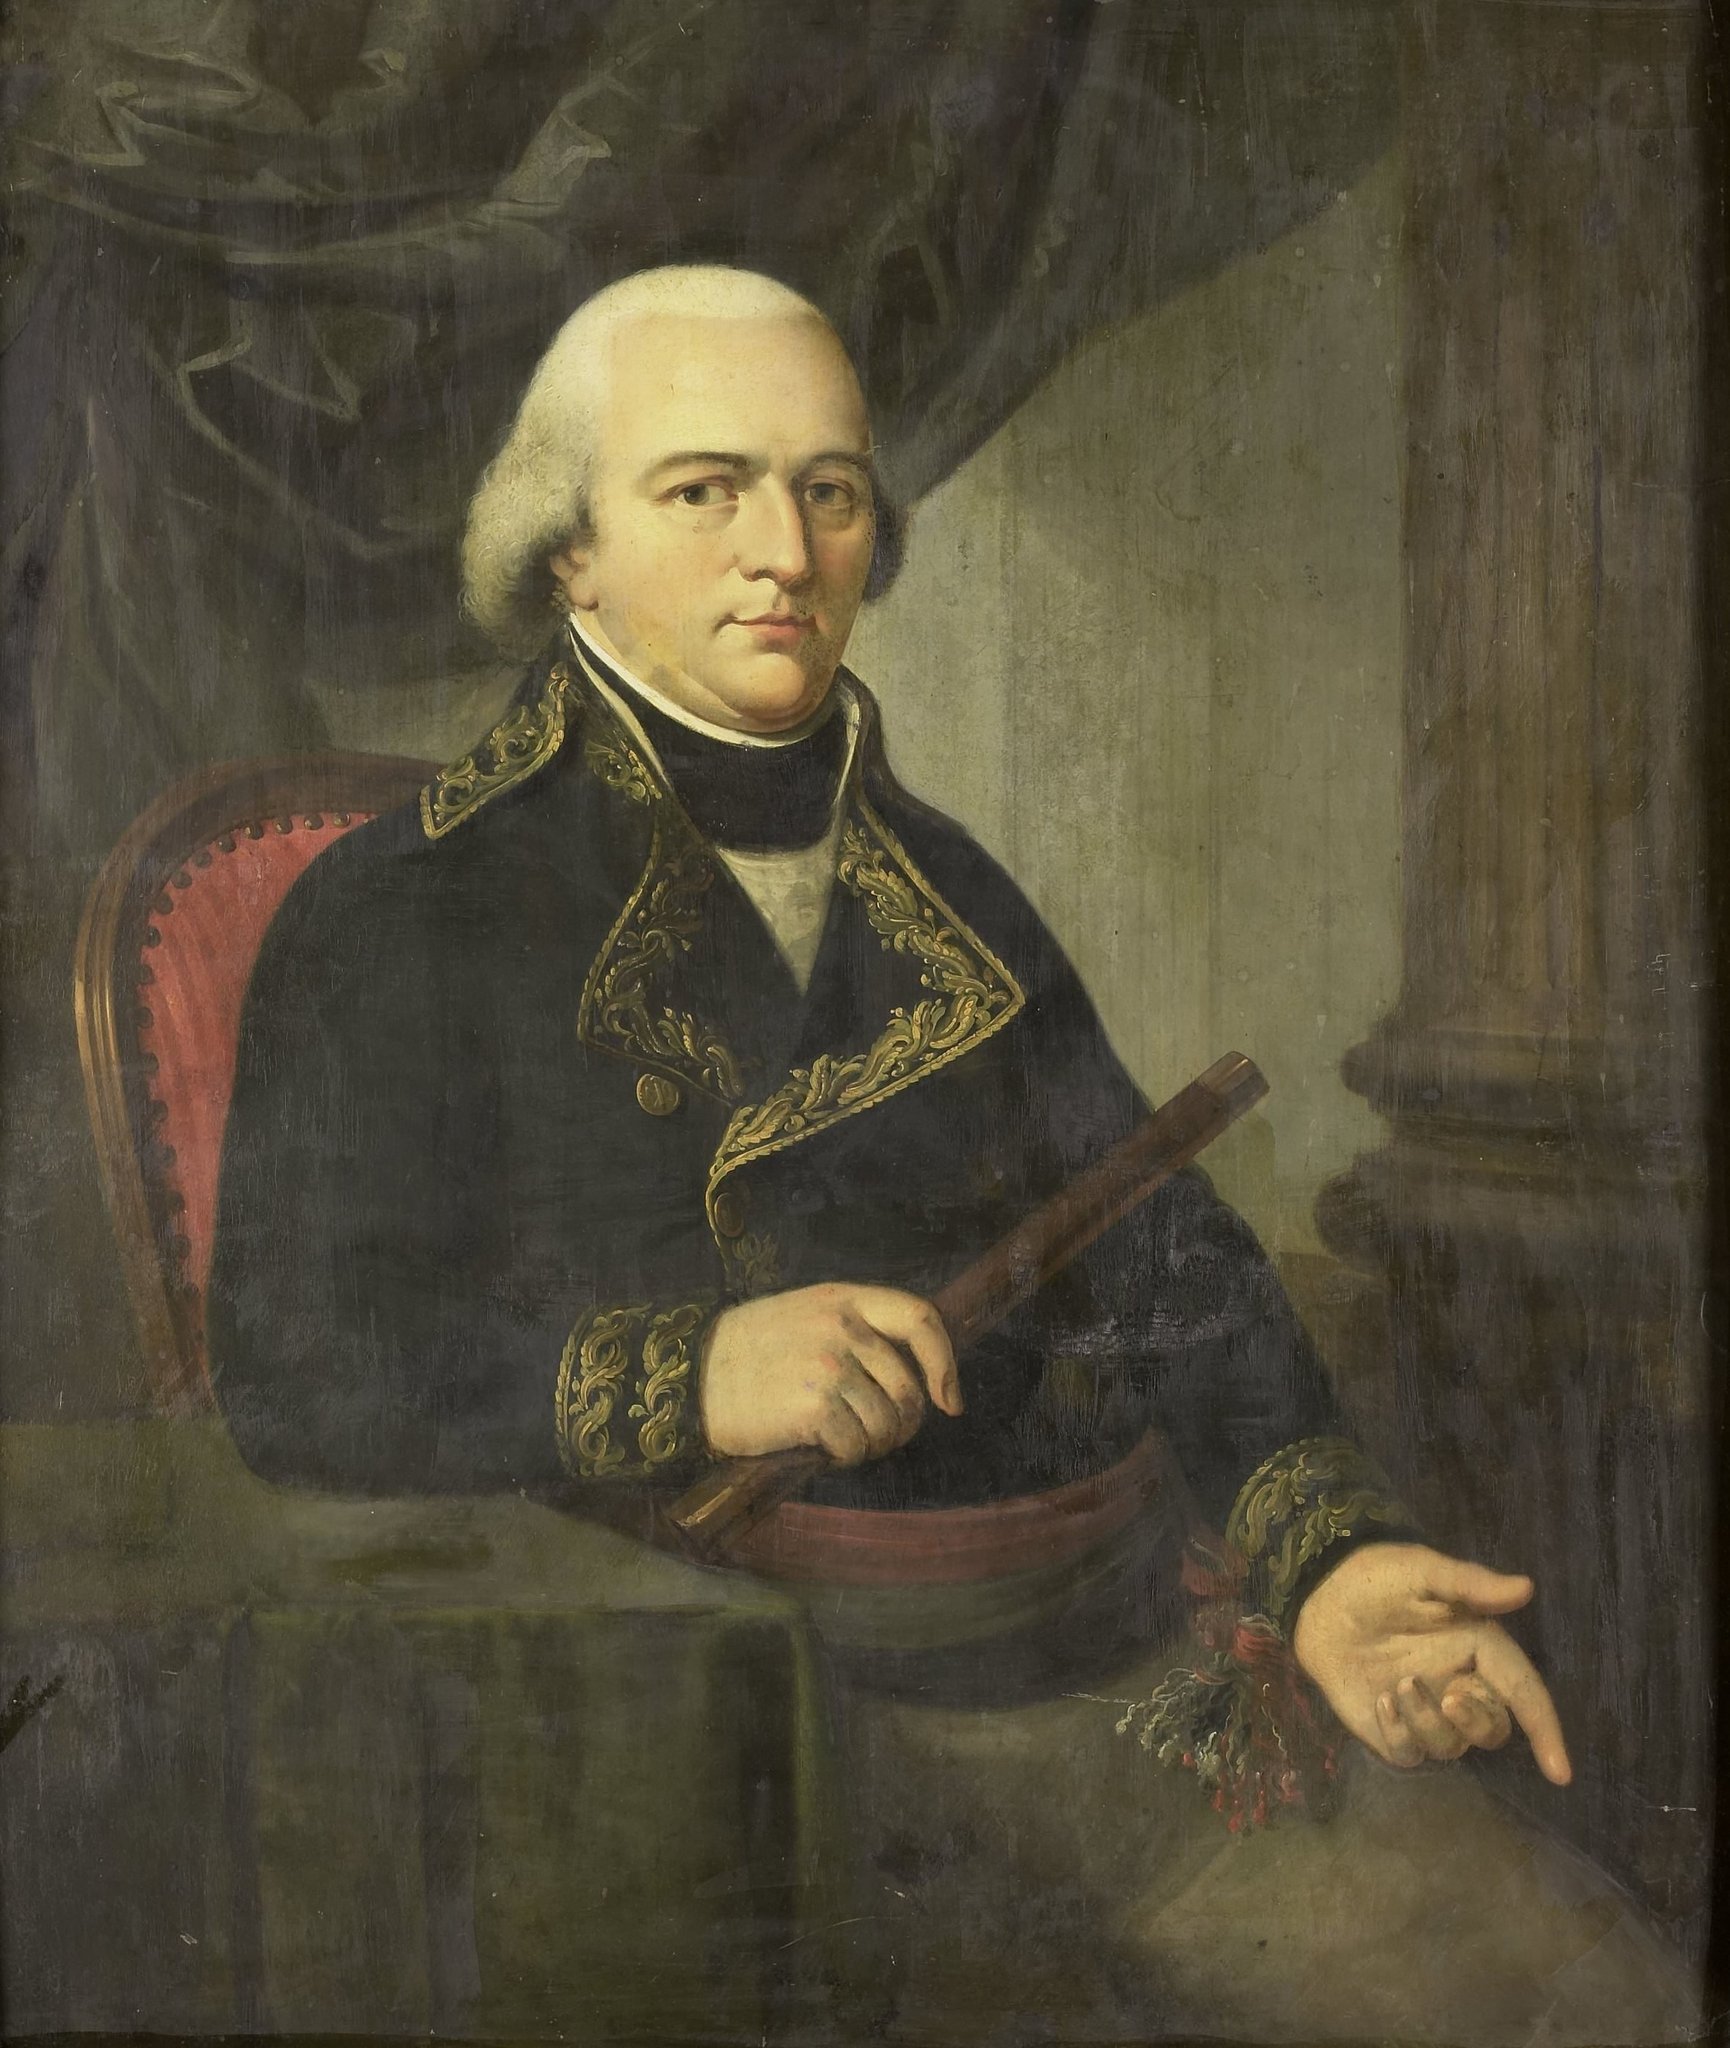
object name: painting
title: Portrait of Pieter Gerardus van Overstraten, Governor-General of the Dutch East Indies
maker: adriaan de lelie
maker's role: draughtsman, painter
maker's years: 1755-1820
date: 1802-1820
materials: copper, oil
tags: colonial governor, historical persons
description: Portret van Pieter Gerardus van Overstraten (1755-1801). Gouverneur-generaal (1797-1801). Kniestuk, naar rechts, zittend in een stoel met de rechterarm steunend op een tafel en met een commandostaf in de rechterhand, gebarend met de linkerhand. De gelaatstrekken gemodelleerd naar een miniatuurportret geschilderd in Batavia door Joseph Gillis. Onderdeel van een reeks van portretten van de gouverneurs-generaal van het voormalige Nederlands Oost-Indië.